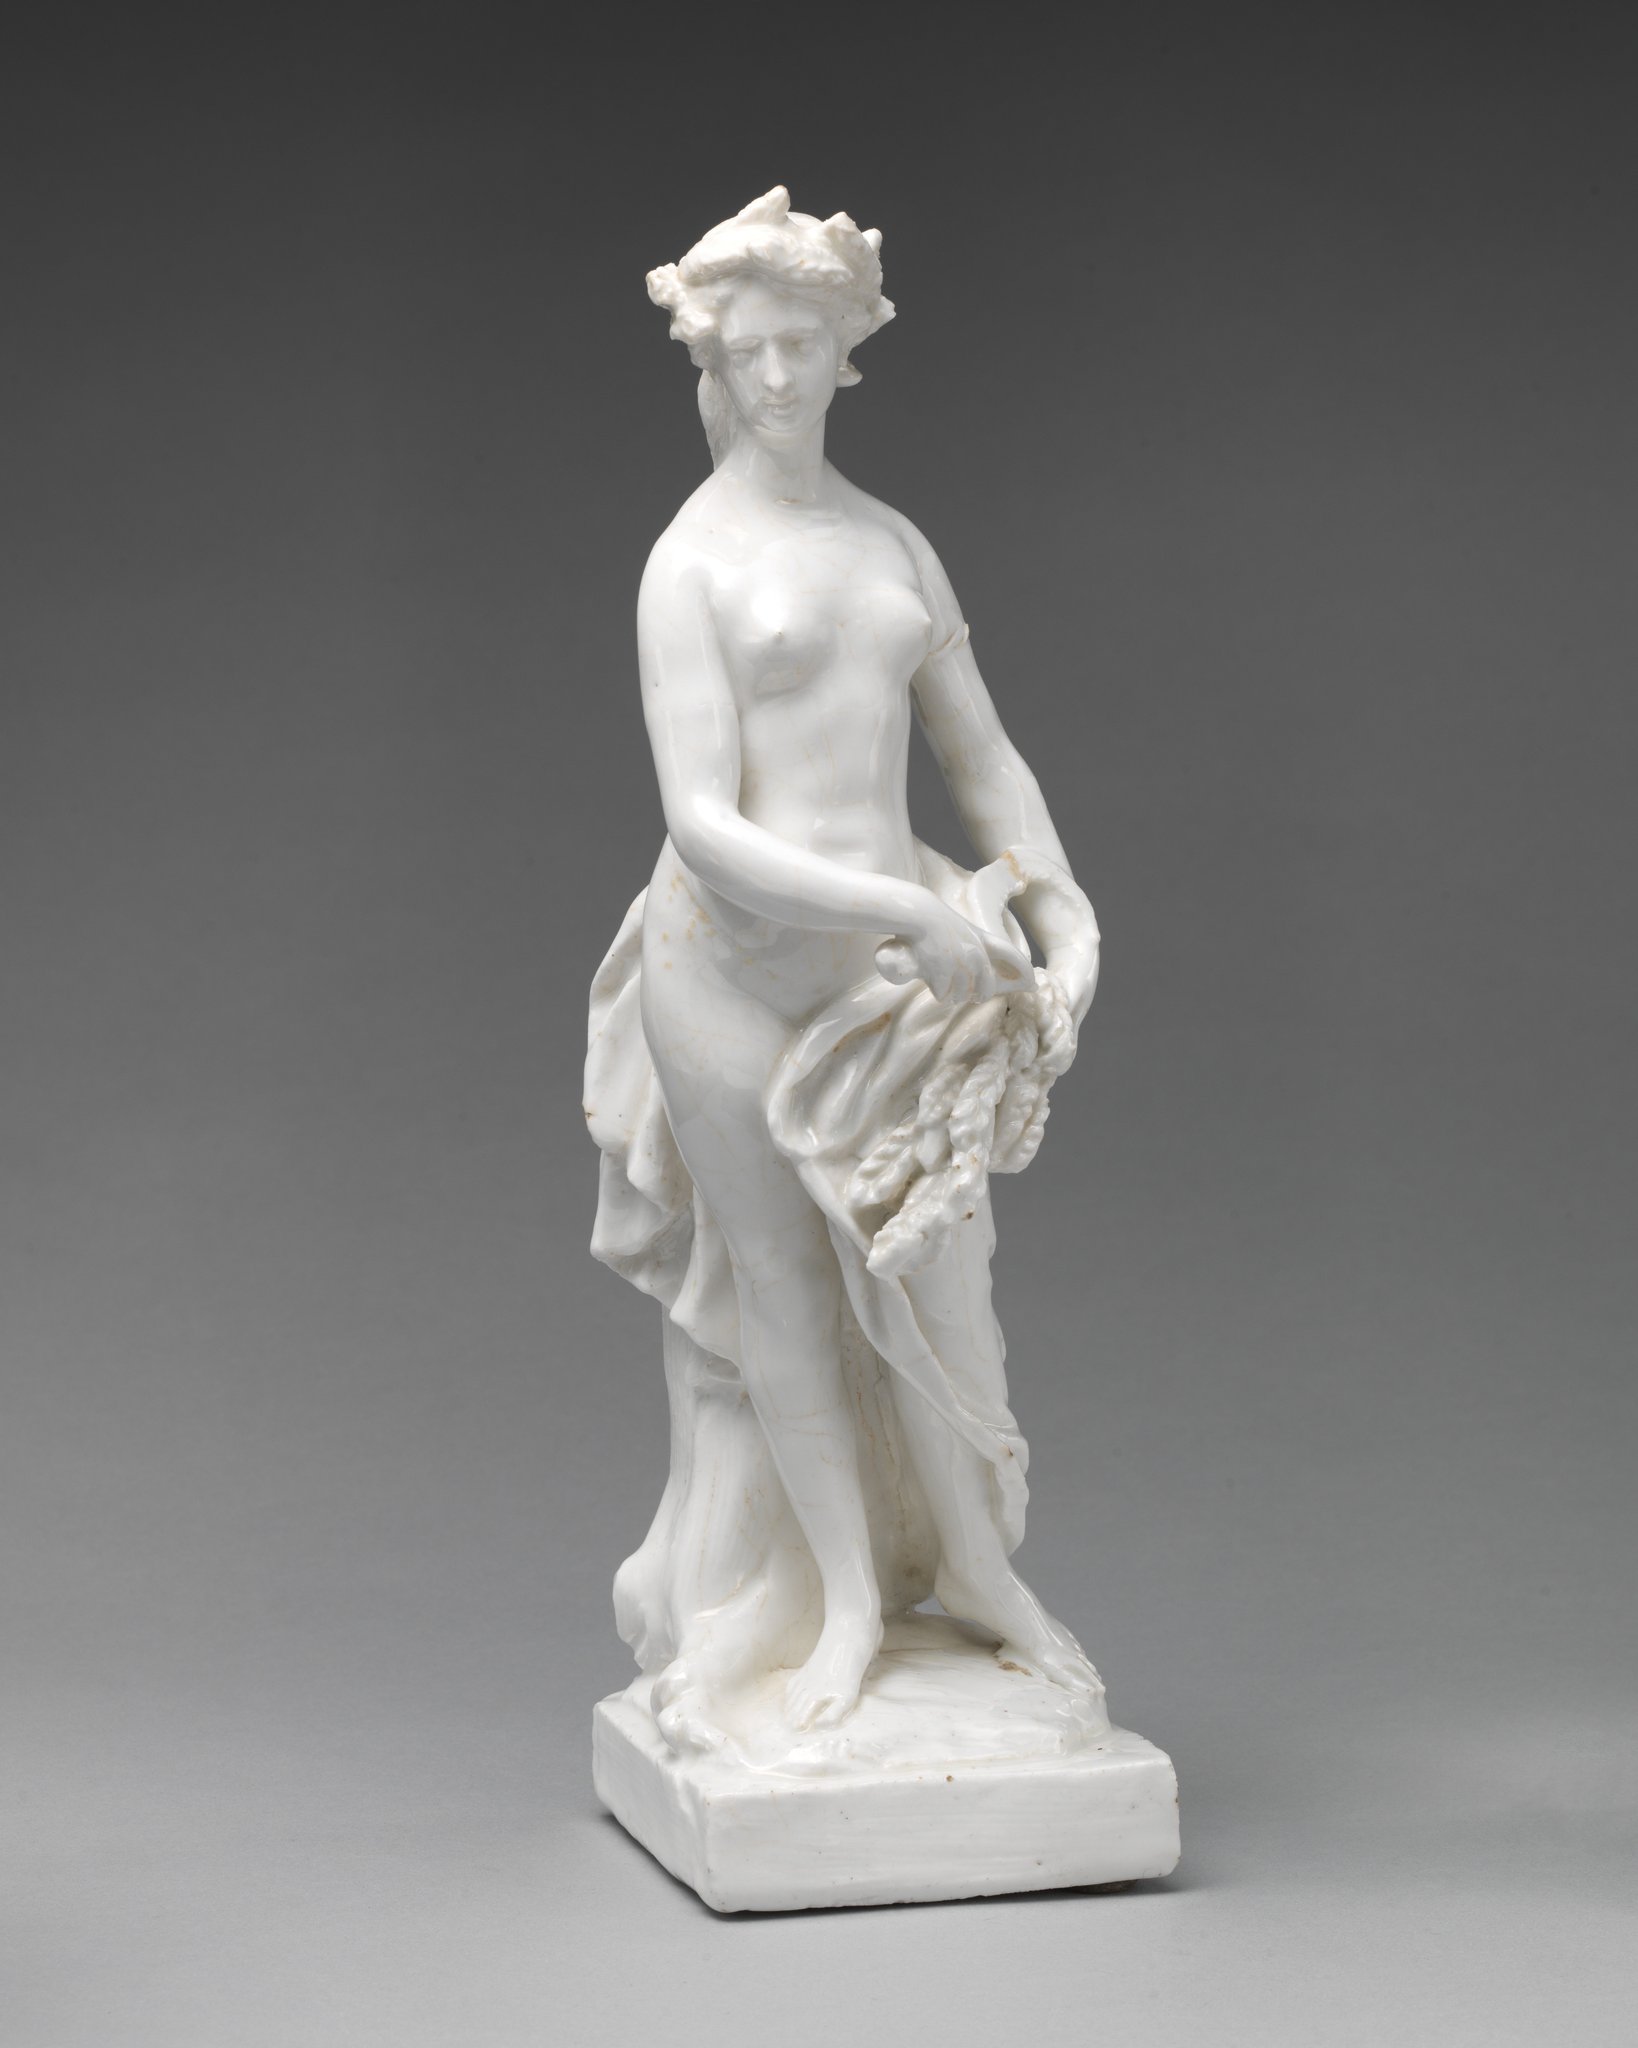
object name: figure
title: Ceres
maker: chelsea porcelain manufactory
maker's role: factory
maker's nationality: british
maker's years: 1744-1784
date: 1748-1750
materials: soft paste porcelain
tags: ceres